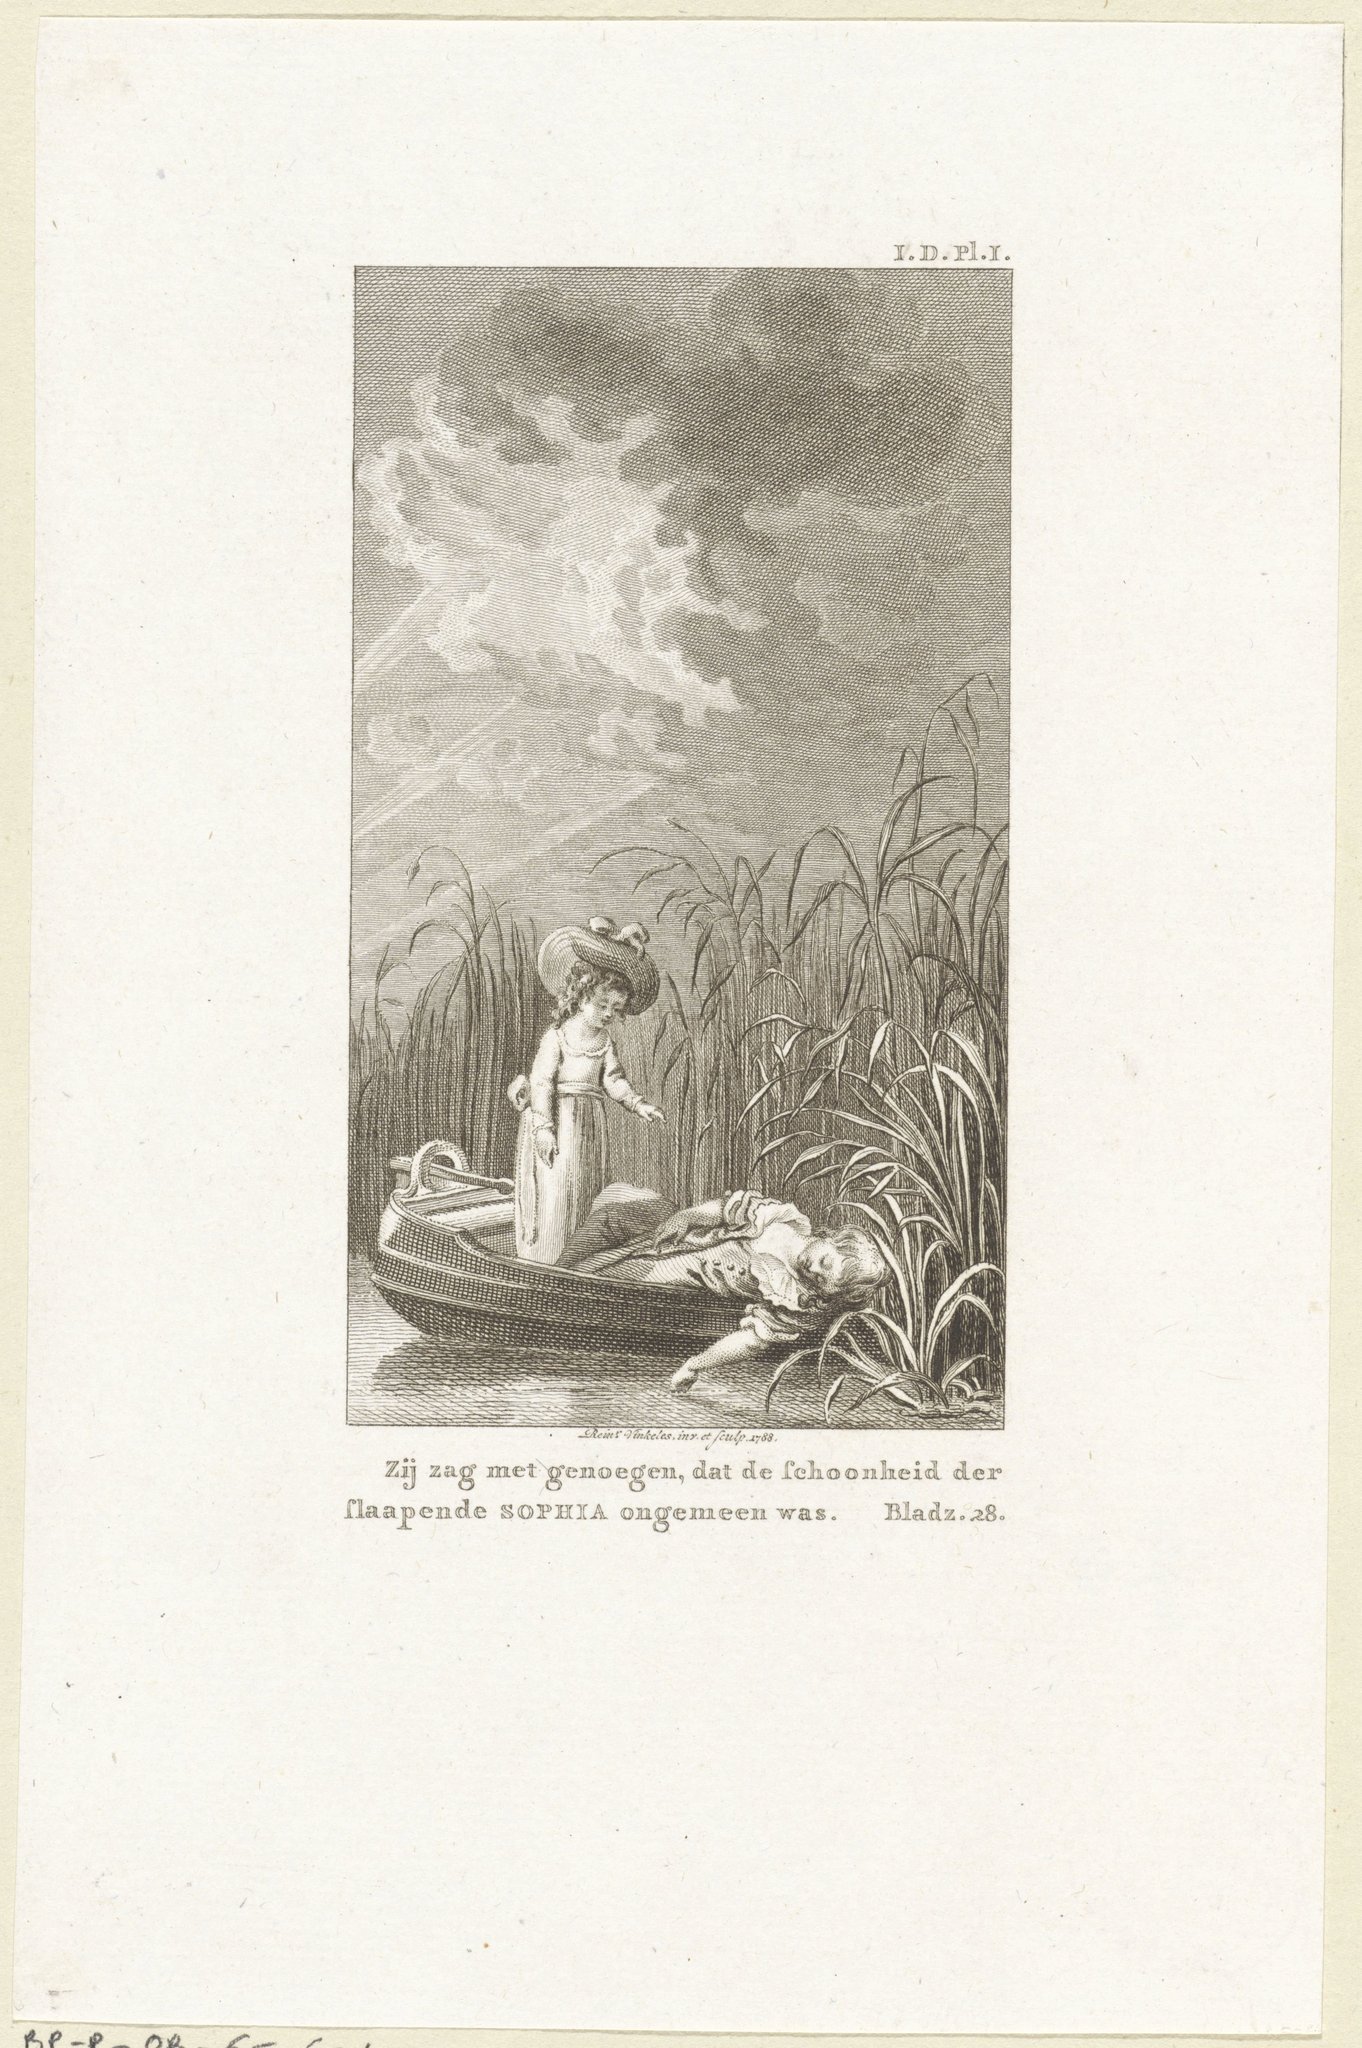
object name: print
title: Meisje wijst op Sophia die in een bootje ligt te slapen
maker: reinier vinkeles (i)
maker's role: draughtsman, print maker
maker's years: 1741-1816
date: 1788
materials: paper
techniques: engraving, etching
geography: amsterdam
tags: rowing-boat, canoe, etc., plants and herbs: reed, sleeping; unconsciousness, index finger forwards, pointing, indicating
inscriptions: inscription: ‘Zij zag met genoegen, dat de schoonheid der / slaapende Sophia ongemeen was. Bladz. 28.’, collector's mark: Lugt 240